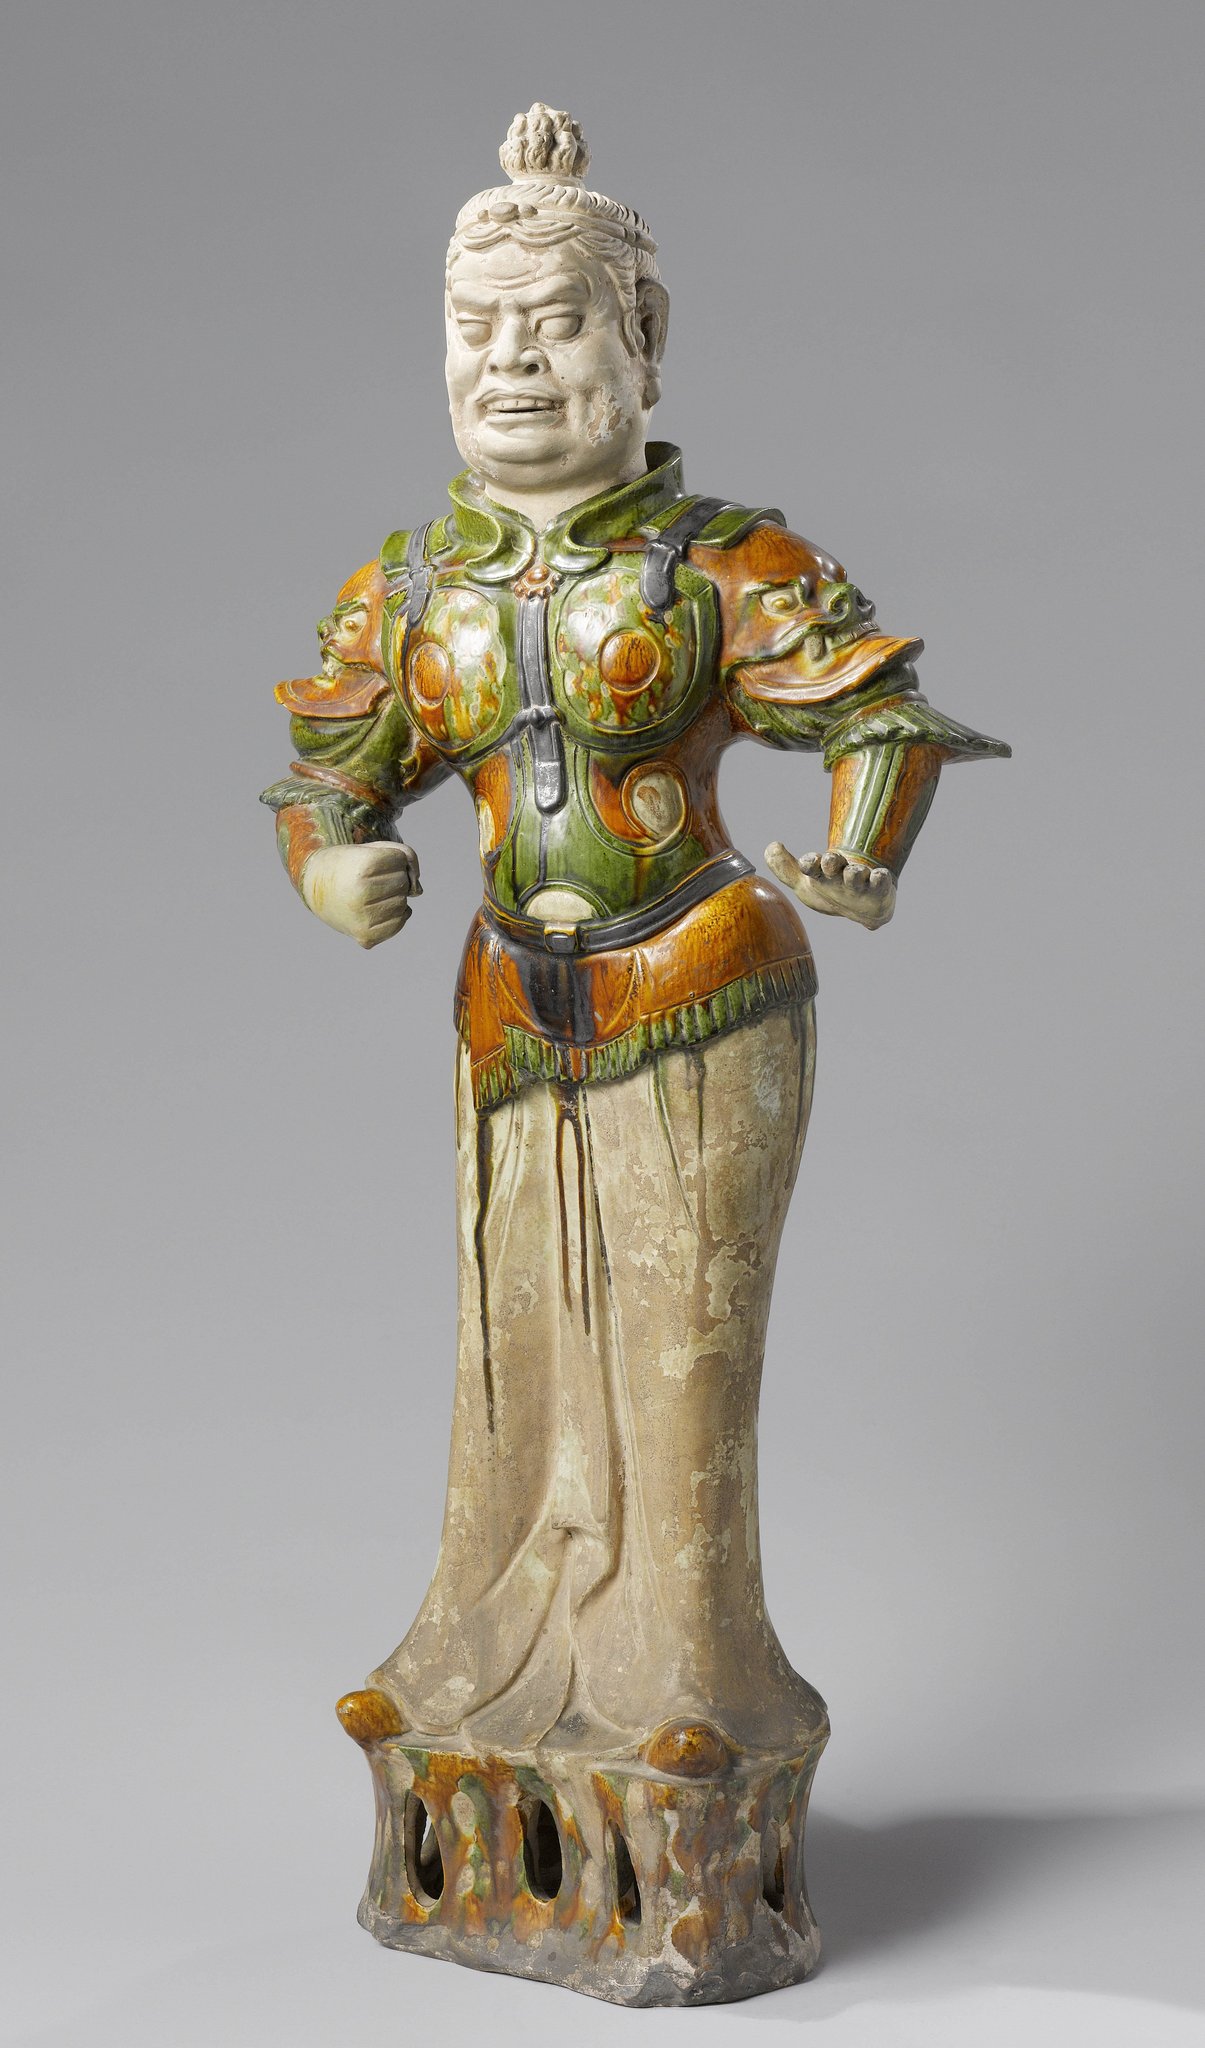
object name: figure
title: Tomb figure of a guardian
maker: Anonymous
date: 618-906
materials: earthenware, glaze, paint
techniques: firing, forming, vitrification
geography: china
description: Graffiguur of beeld van aardewerk in de vorm van een wachter met een haarknot, gedeeltelijk bedekt met een groen en geel glazuur. Tang.